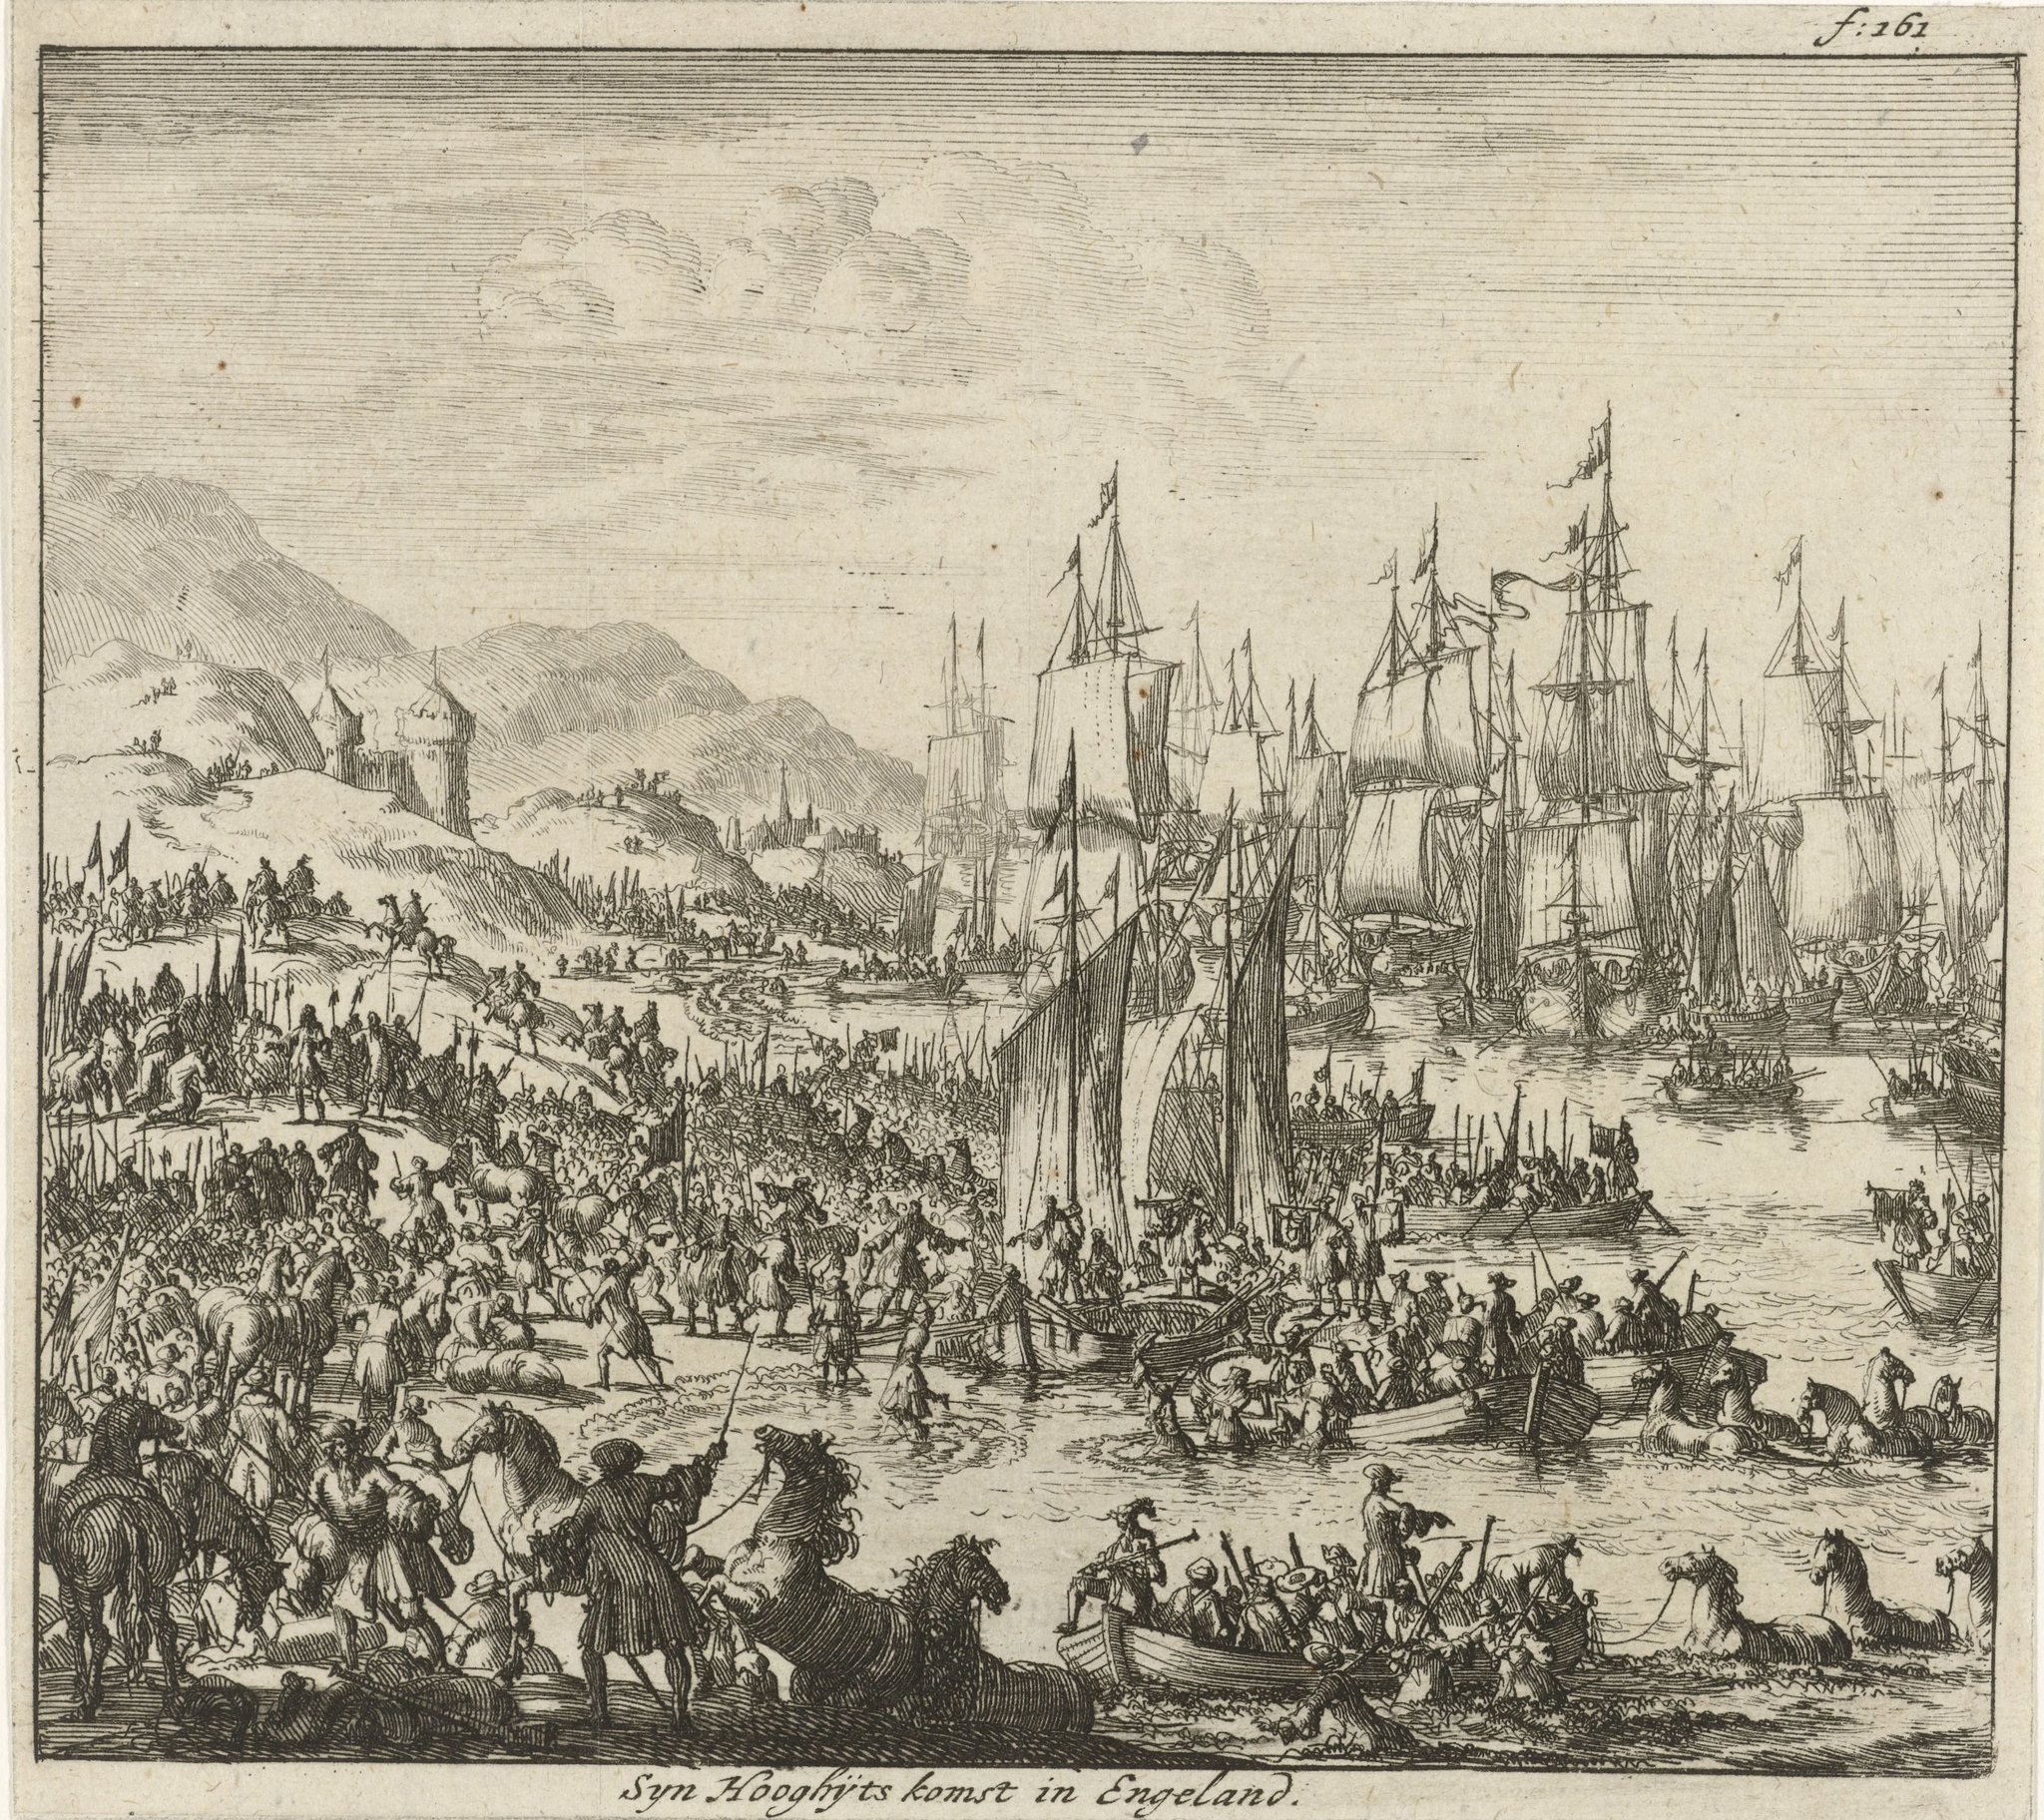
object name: print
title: Syn Hooghijts komst in Engeland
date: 1689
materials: paper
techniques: etching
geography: amsterdam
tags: arrival and return ~ travelling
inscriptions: collector's mark: Lugt 2228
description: Aankomst van de vloot met prins Willem III bij Torbay in Engeland, 15 november 1688. Prent rechtsboven gemerkt: f: 161.